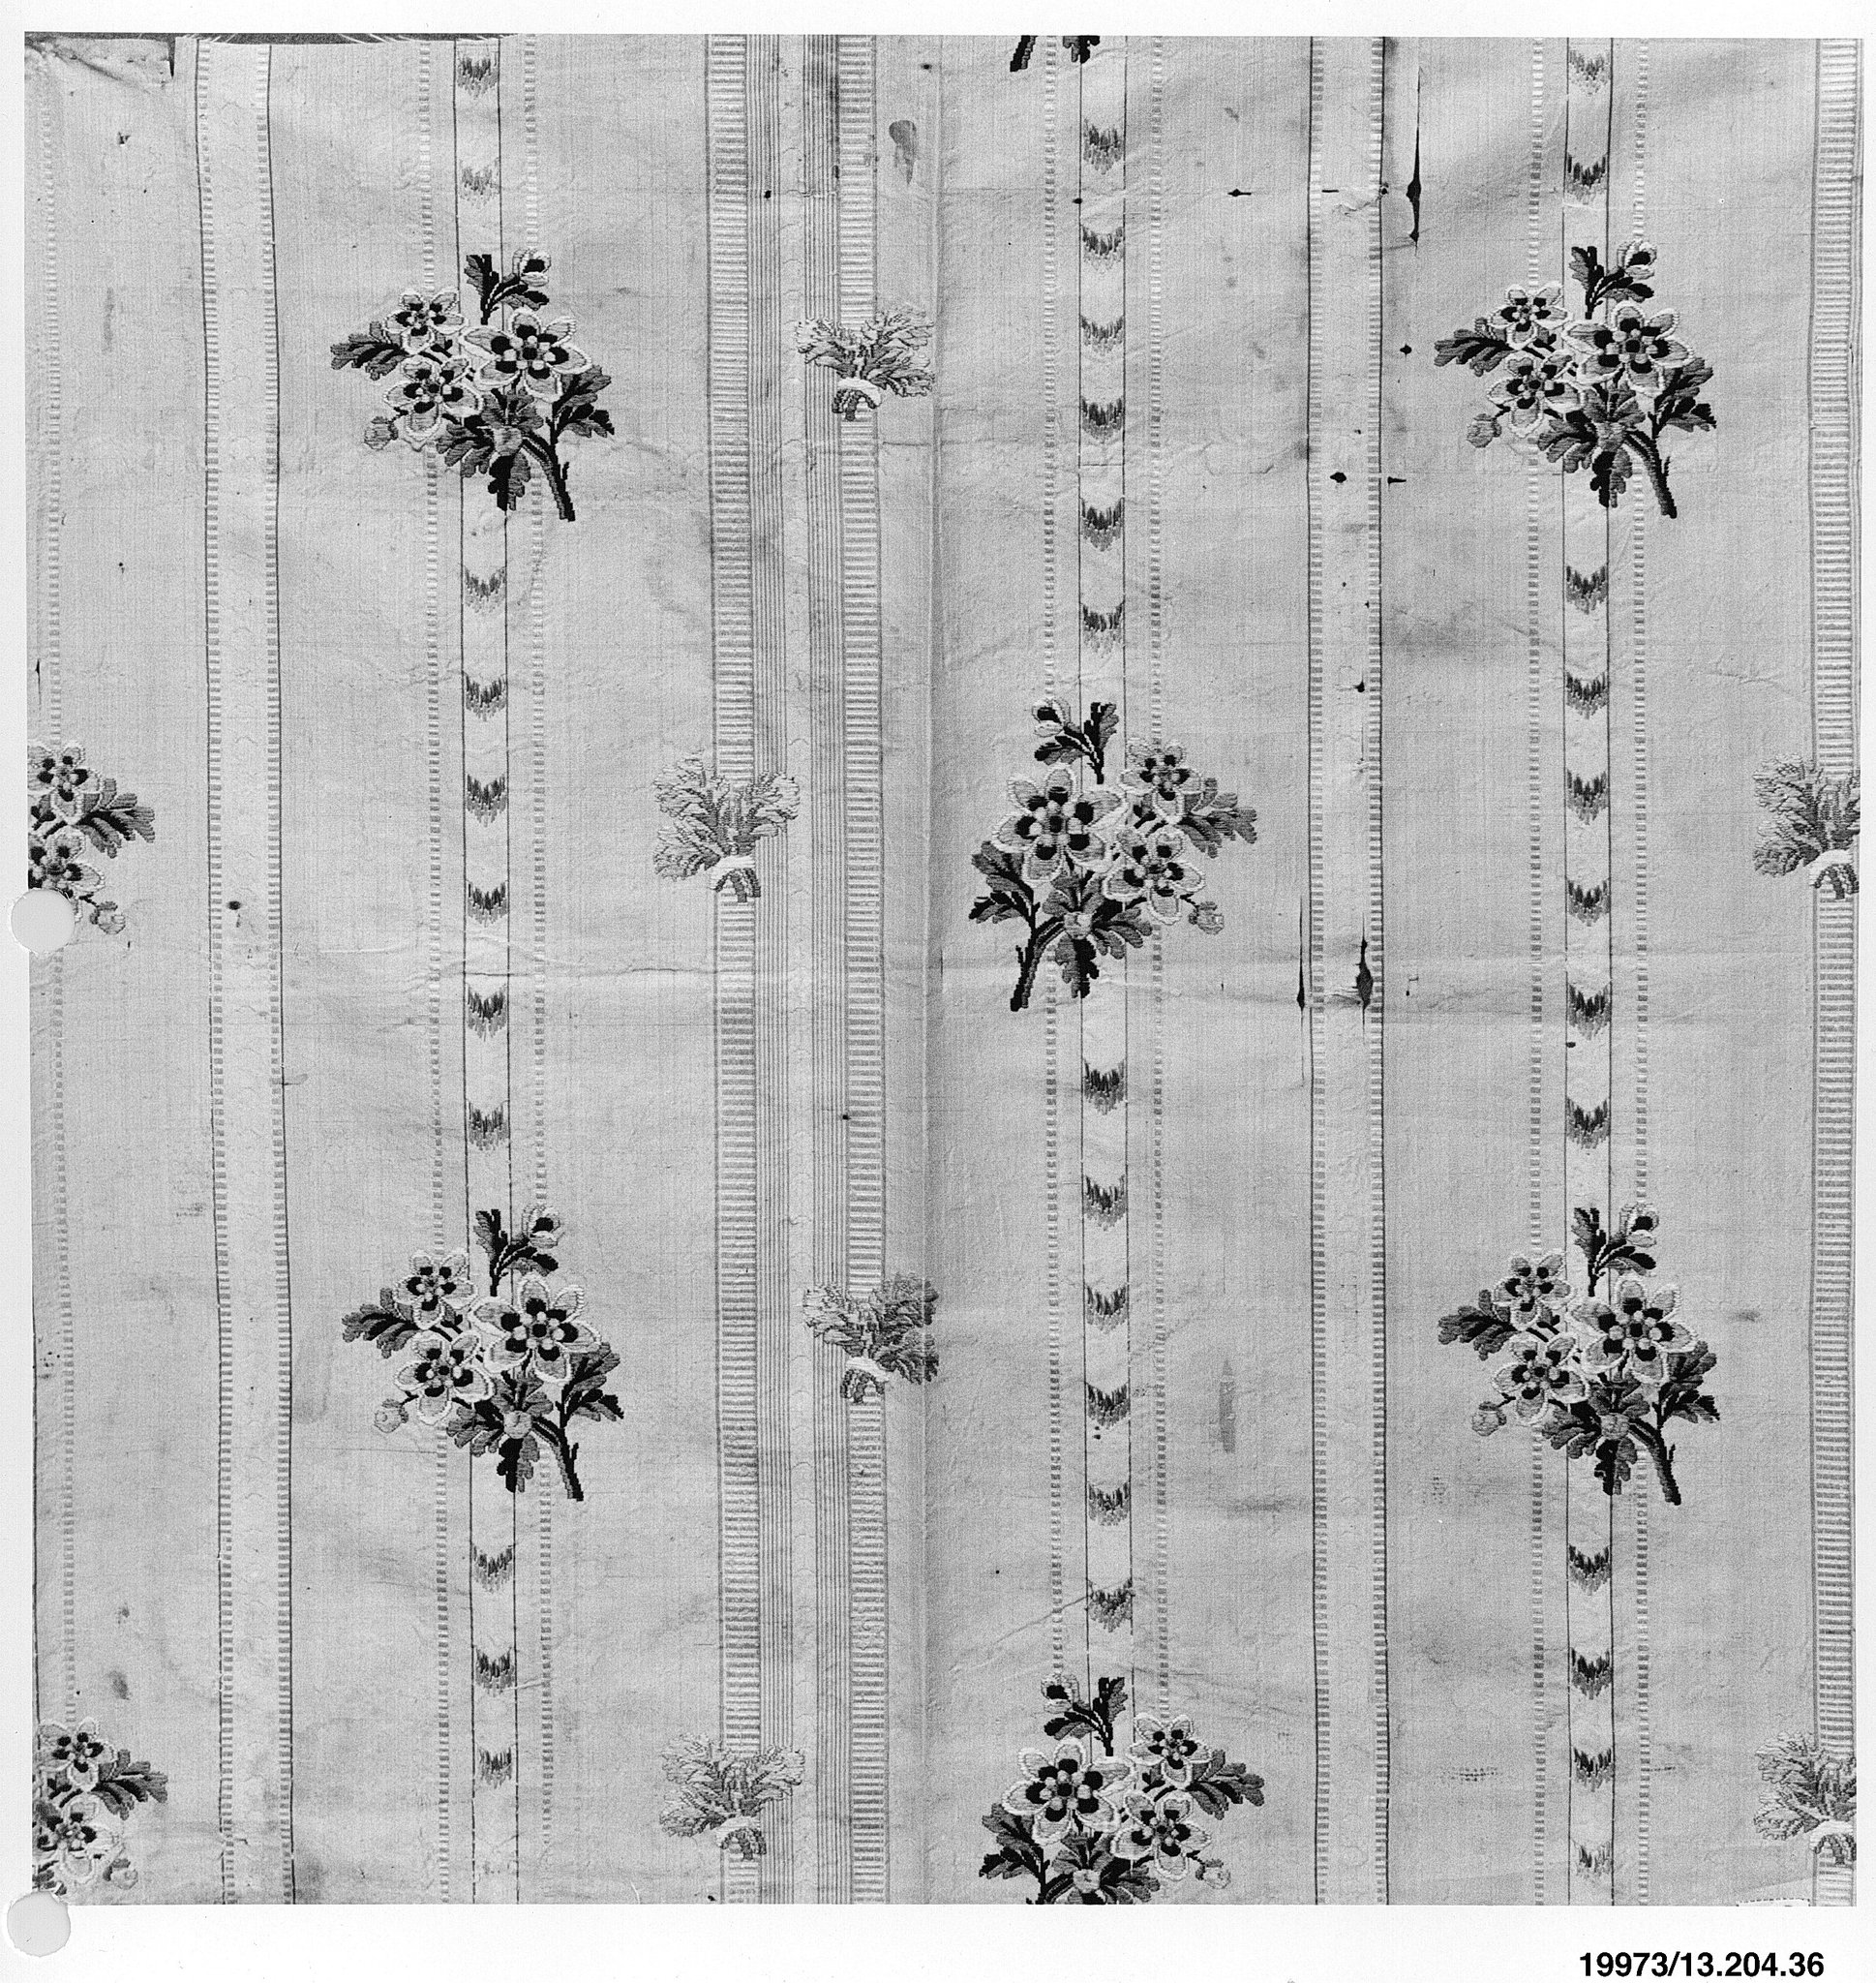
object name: piece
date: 1767-1800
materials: silk